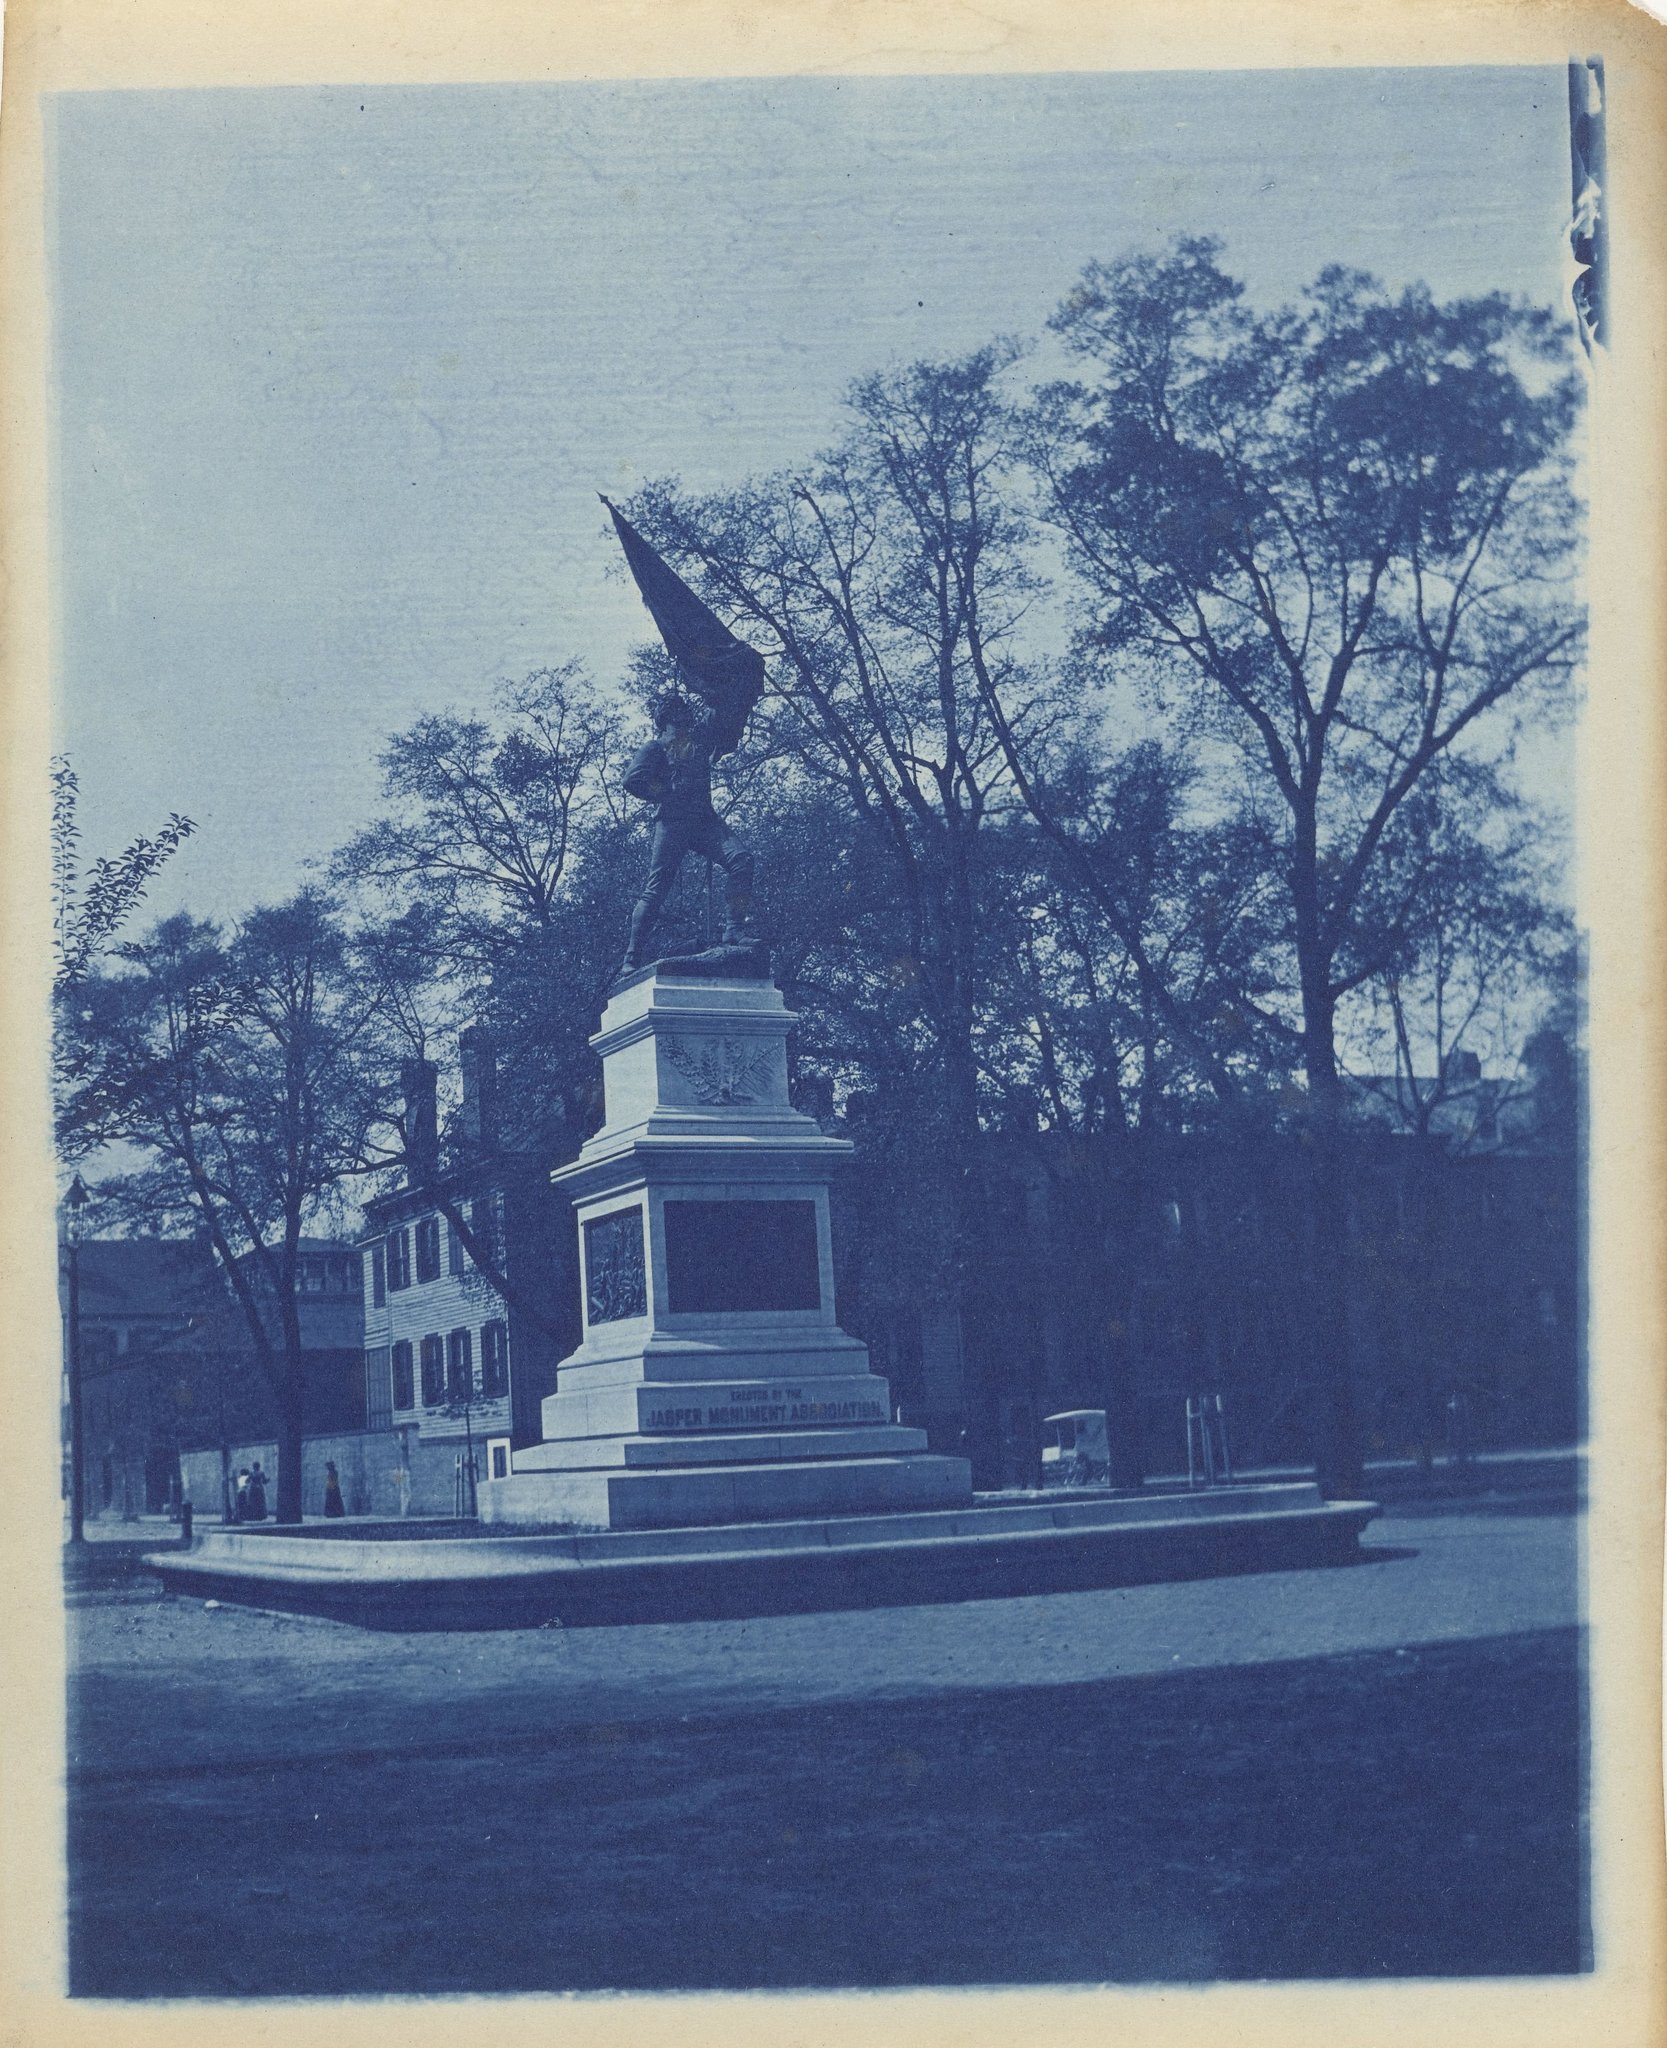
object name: photograph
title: Gezicht op Jasper Monument op Madison Square, Savannah, Georgia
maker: Anonymous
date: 1890-1920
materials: paper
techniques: cyanotype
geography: savannah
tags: monument, statue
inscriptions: inscription: ‘0399 of 0355’